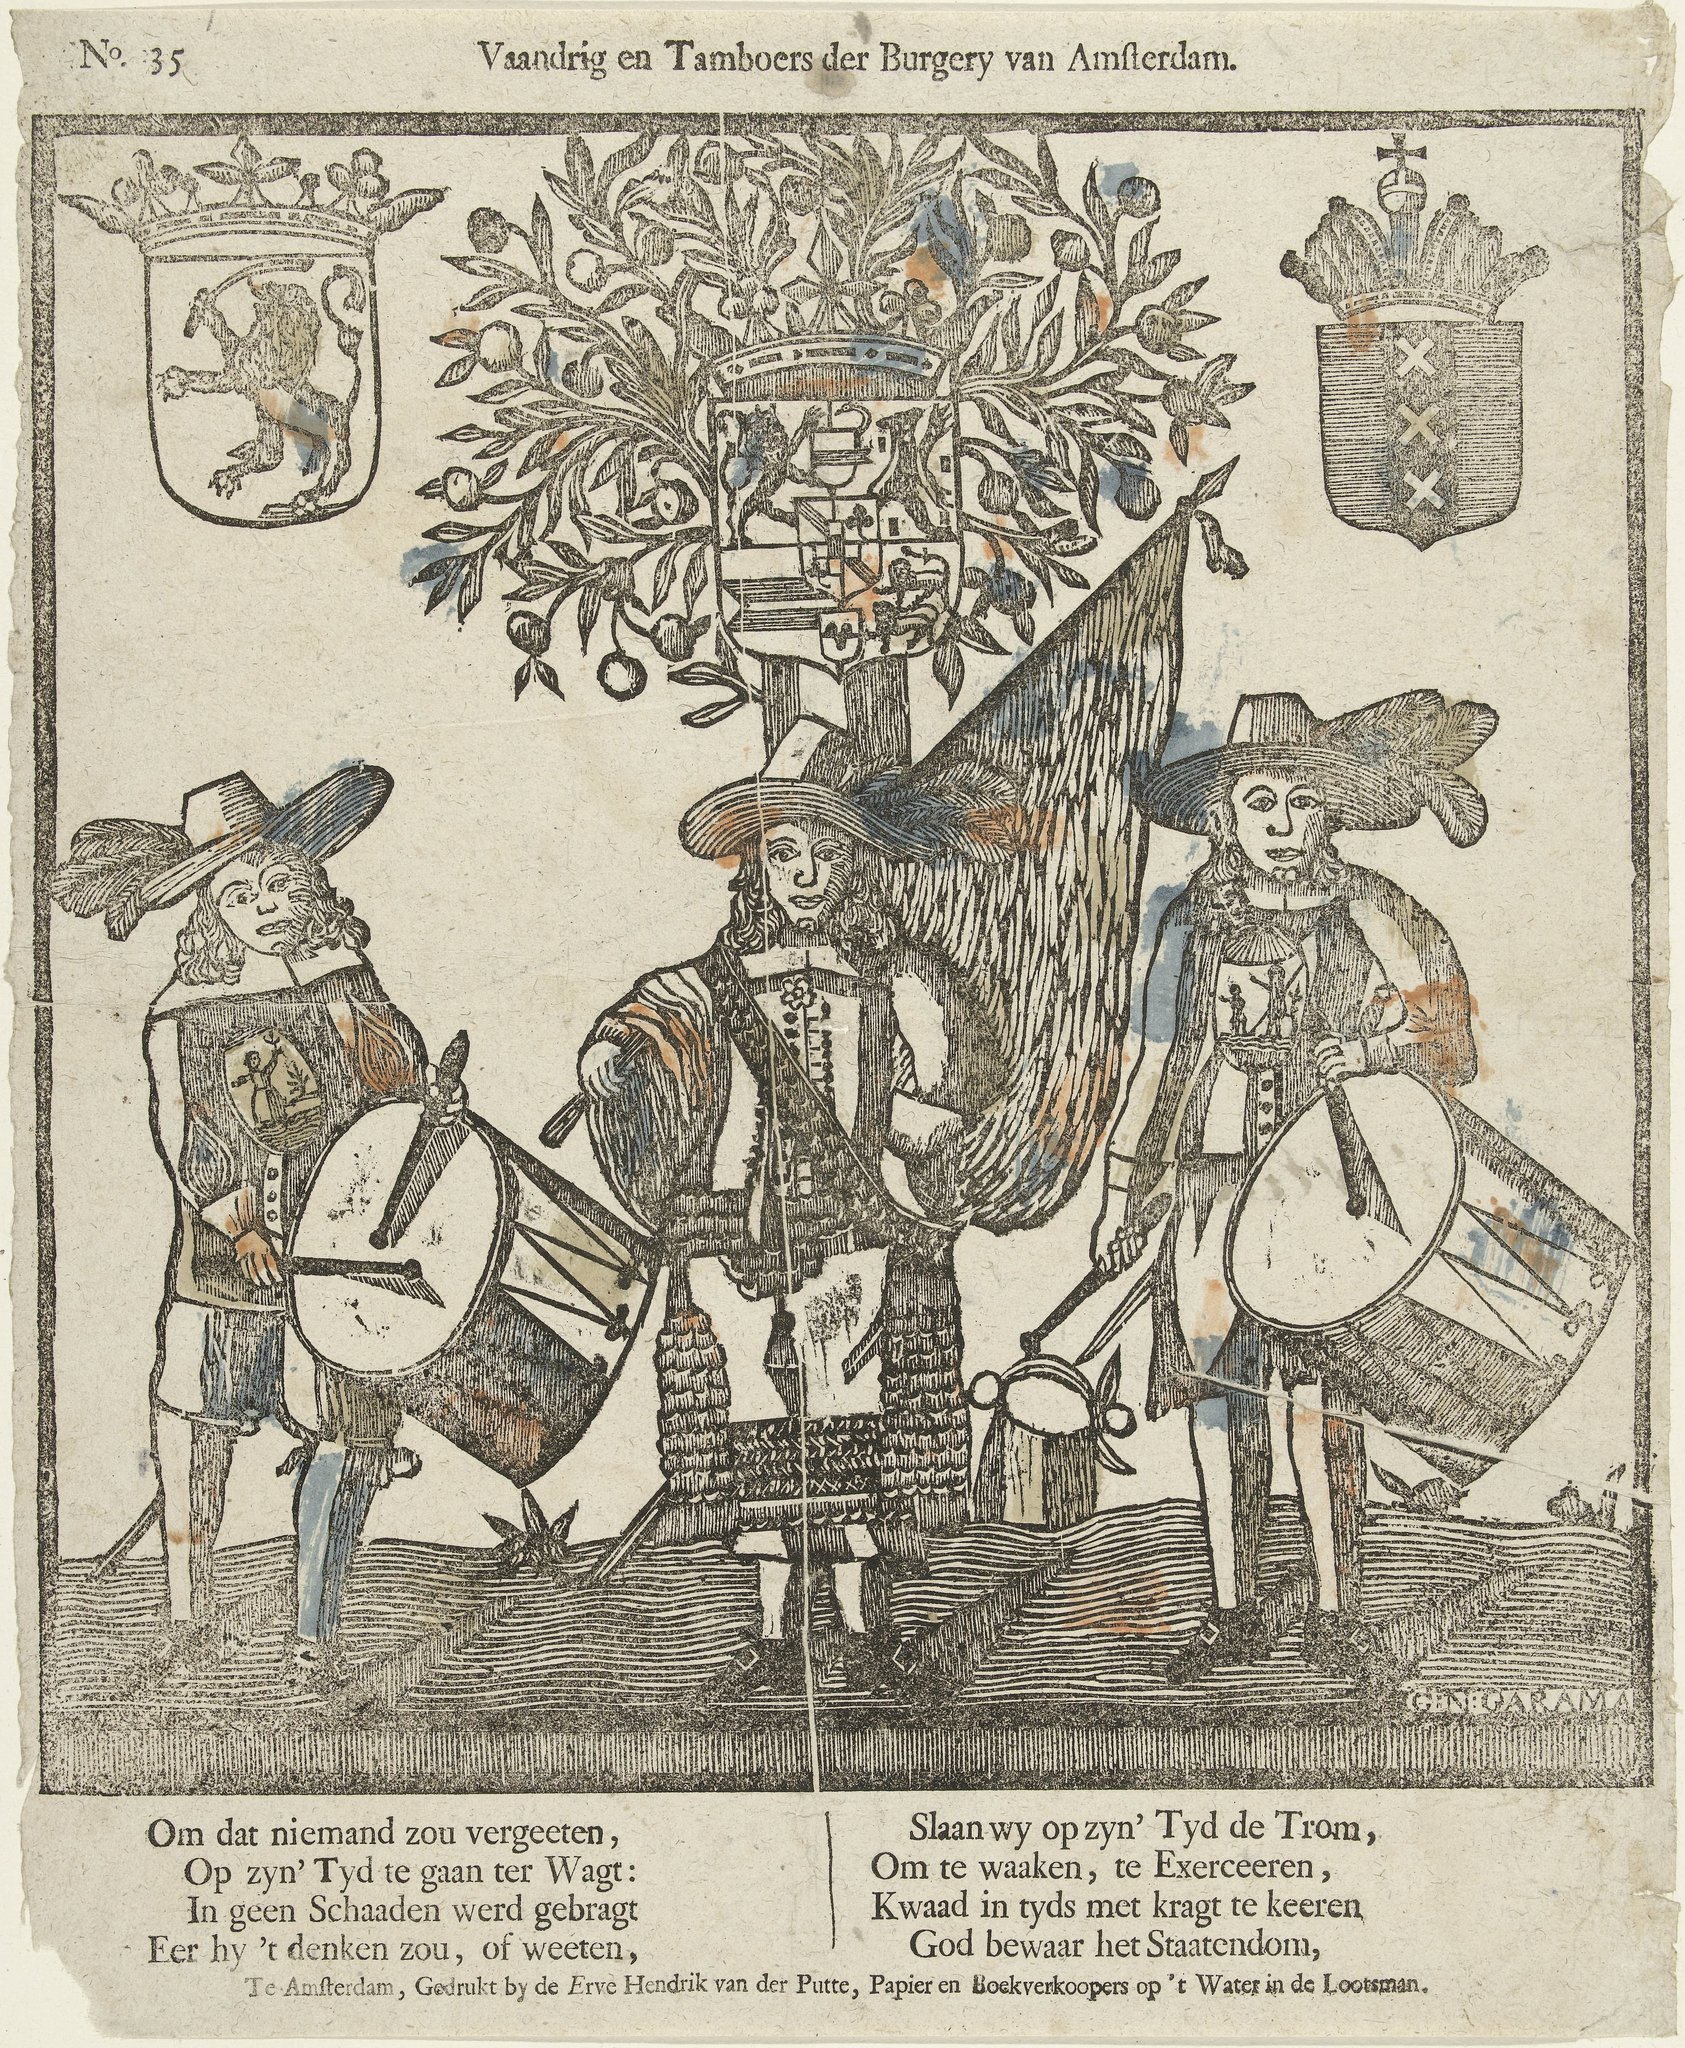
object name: print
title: Vaandrig en tamboers der burgery van Amsterdam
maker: g.n. garama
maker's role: houtsnijder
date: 1767-1793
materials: paper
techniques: colour, letterpress printing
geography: amsterdam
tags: military music, drum (musical instrument)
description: Blad met een grote voorstelling van twee tamboers en een vaandeldrager, staande voor de oranjeboom waaraan het wapen een prins van Oranje-Nassau hangt. Bovenaan ook de wapens van Holland en Amsterdam. Onder de voorstelling twee vierregelige verzen in twee kolommen. Genummerd linksboven: No. 35.